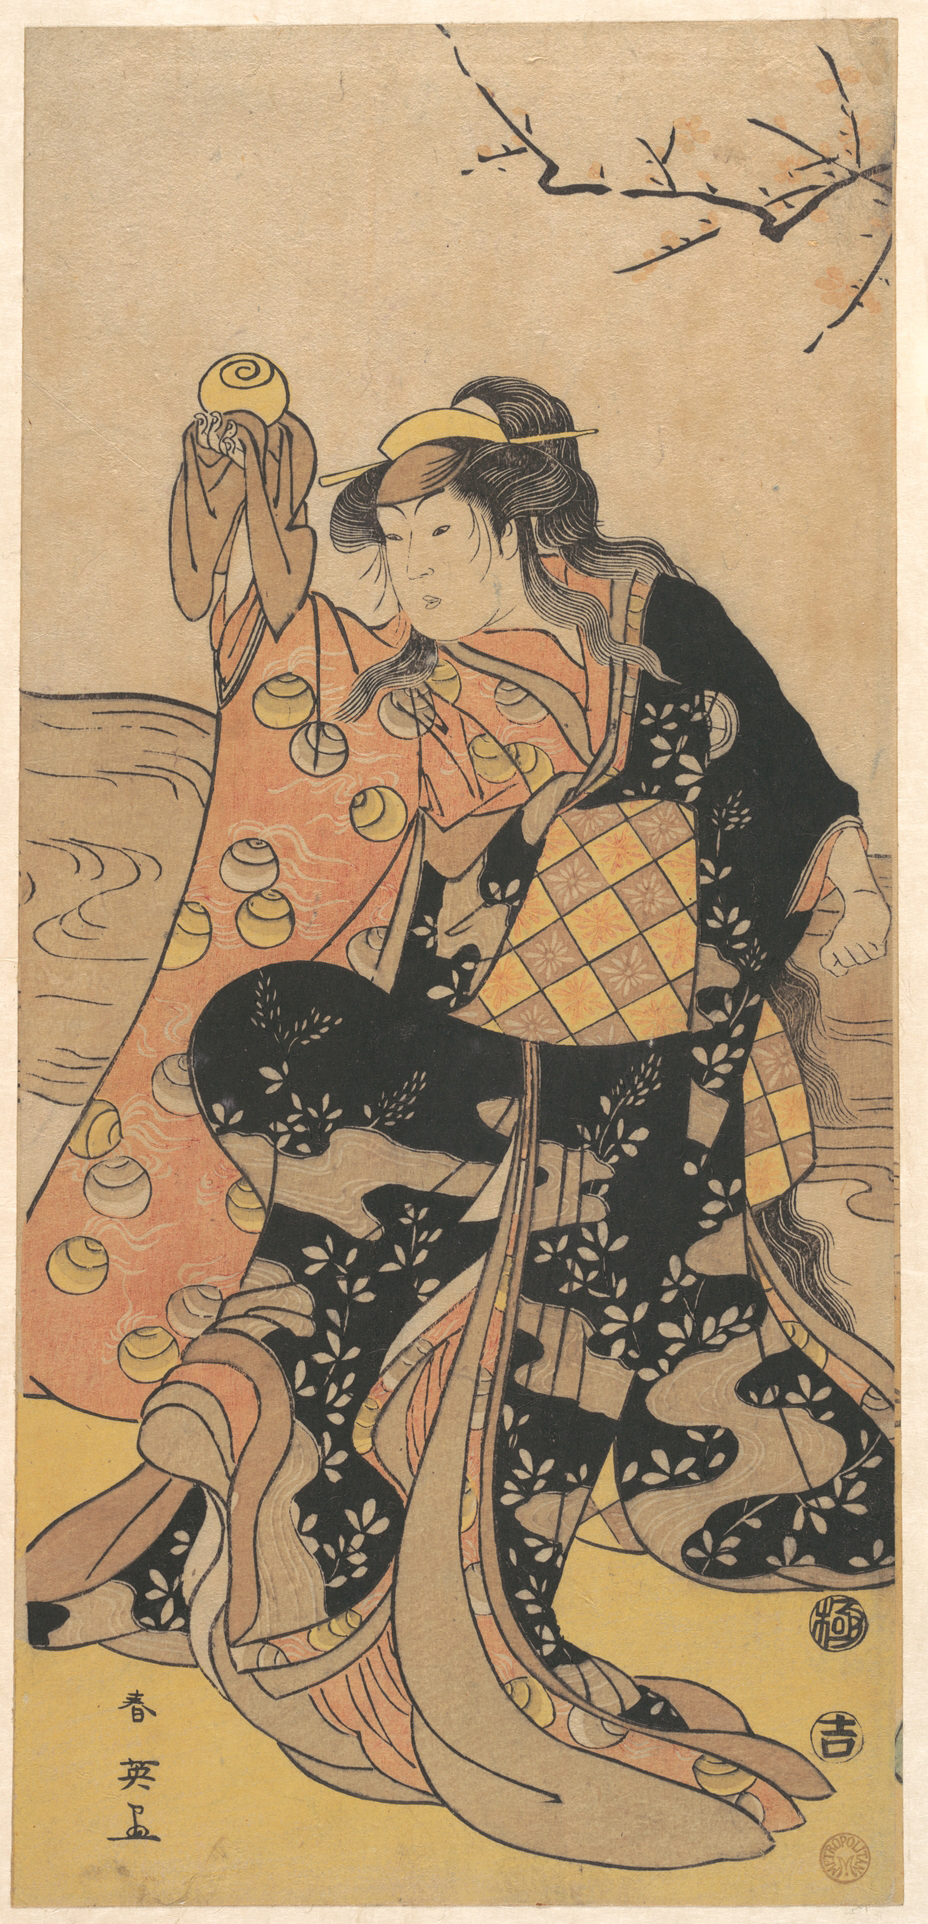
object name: print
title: The Fourth Iwai Hanshiro as a Woman Holding a Crystal Ball and Dancing on the Bank of a Stream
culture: japanese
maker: katsukawa shun'ei 勝川春英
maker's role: artist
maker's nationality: japanese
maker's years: 1762-1819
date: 1788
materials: ink, paper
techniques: woodblock print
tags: dancing,actors